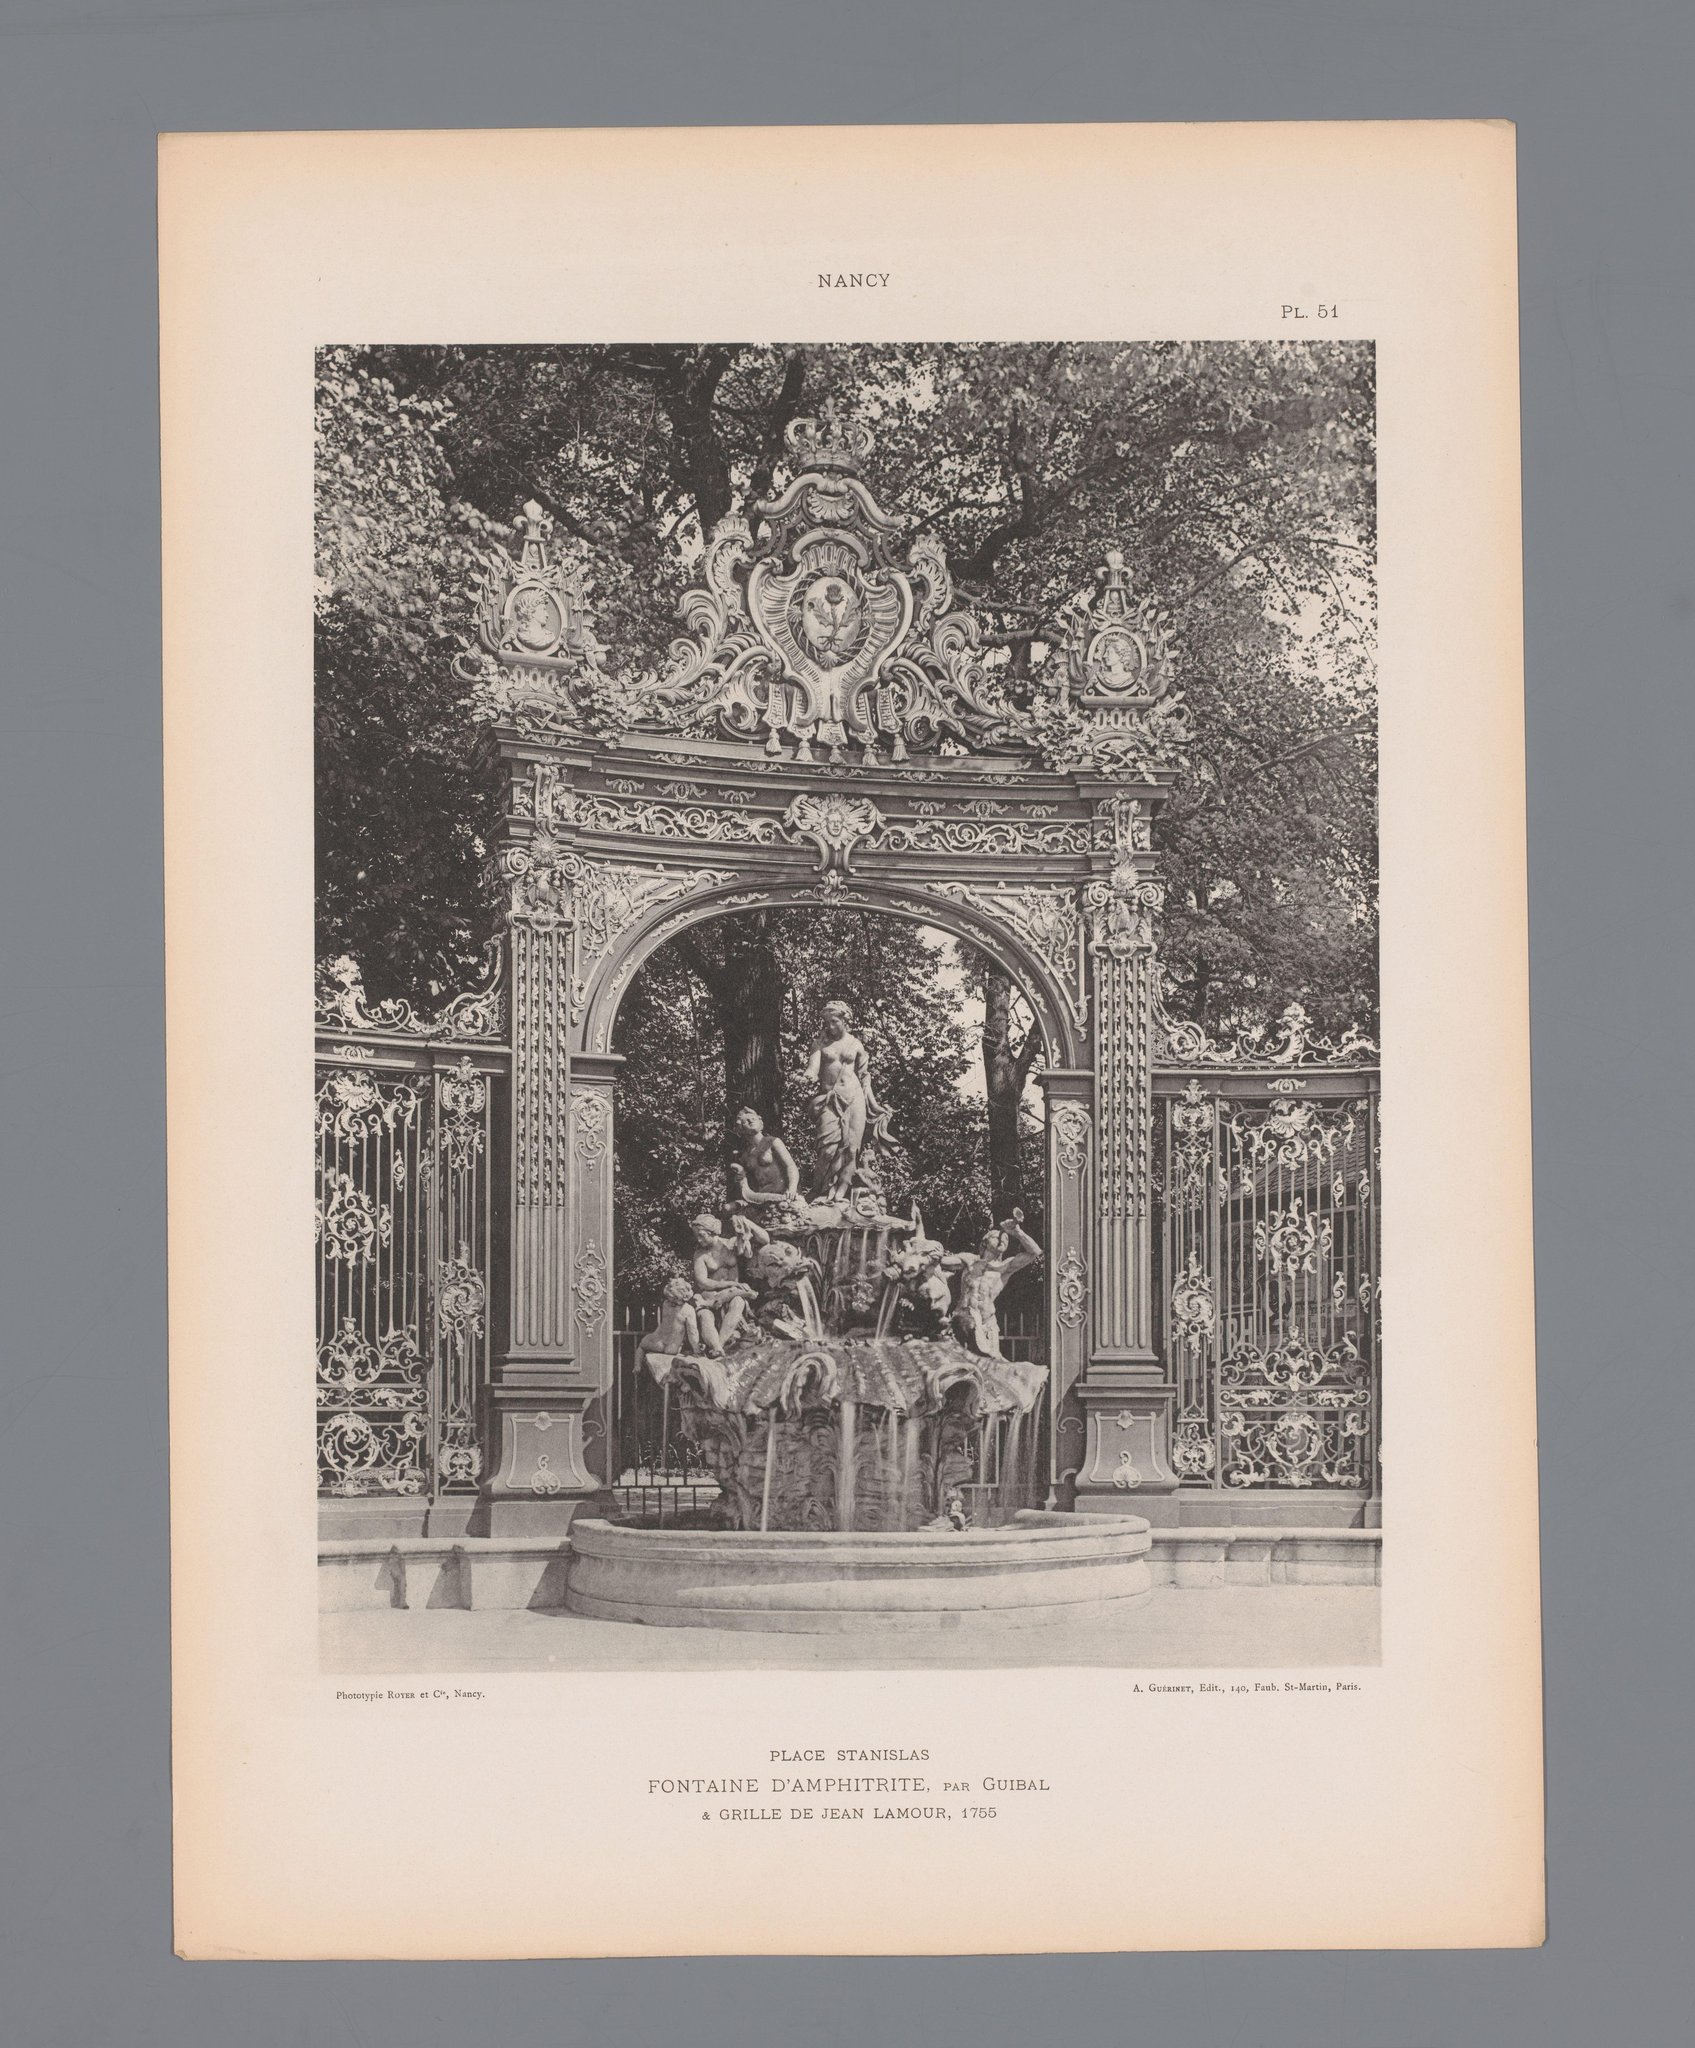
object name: photomechanical print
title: Fontein van Amphitrite op Place Stanislas te Nancy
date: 1891-1896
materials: paper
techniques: photograph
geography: nancy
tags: square, place, circus, etc., (story of) amphitrite, ornamental fountain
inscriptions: inscription: ‘Place Stanislas/ Fontaine d'Amphitrite, par Guibal/ & Grilles de Jean Lamour, 1755’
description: Deze prent maakt deel uit van een omslag met 103 prenten op 101 bladen en een titelblad.